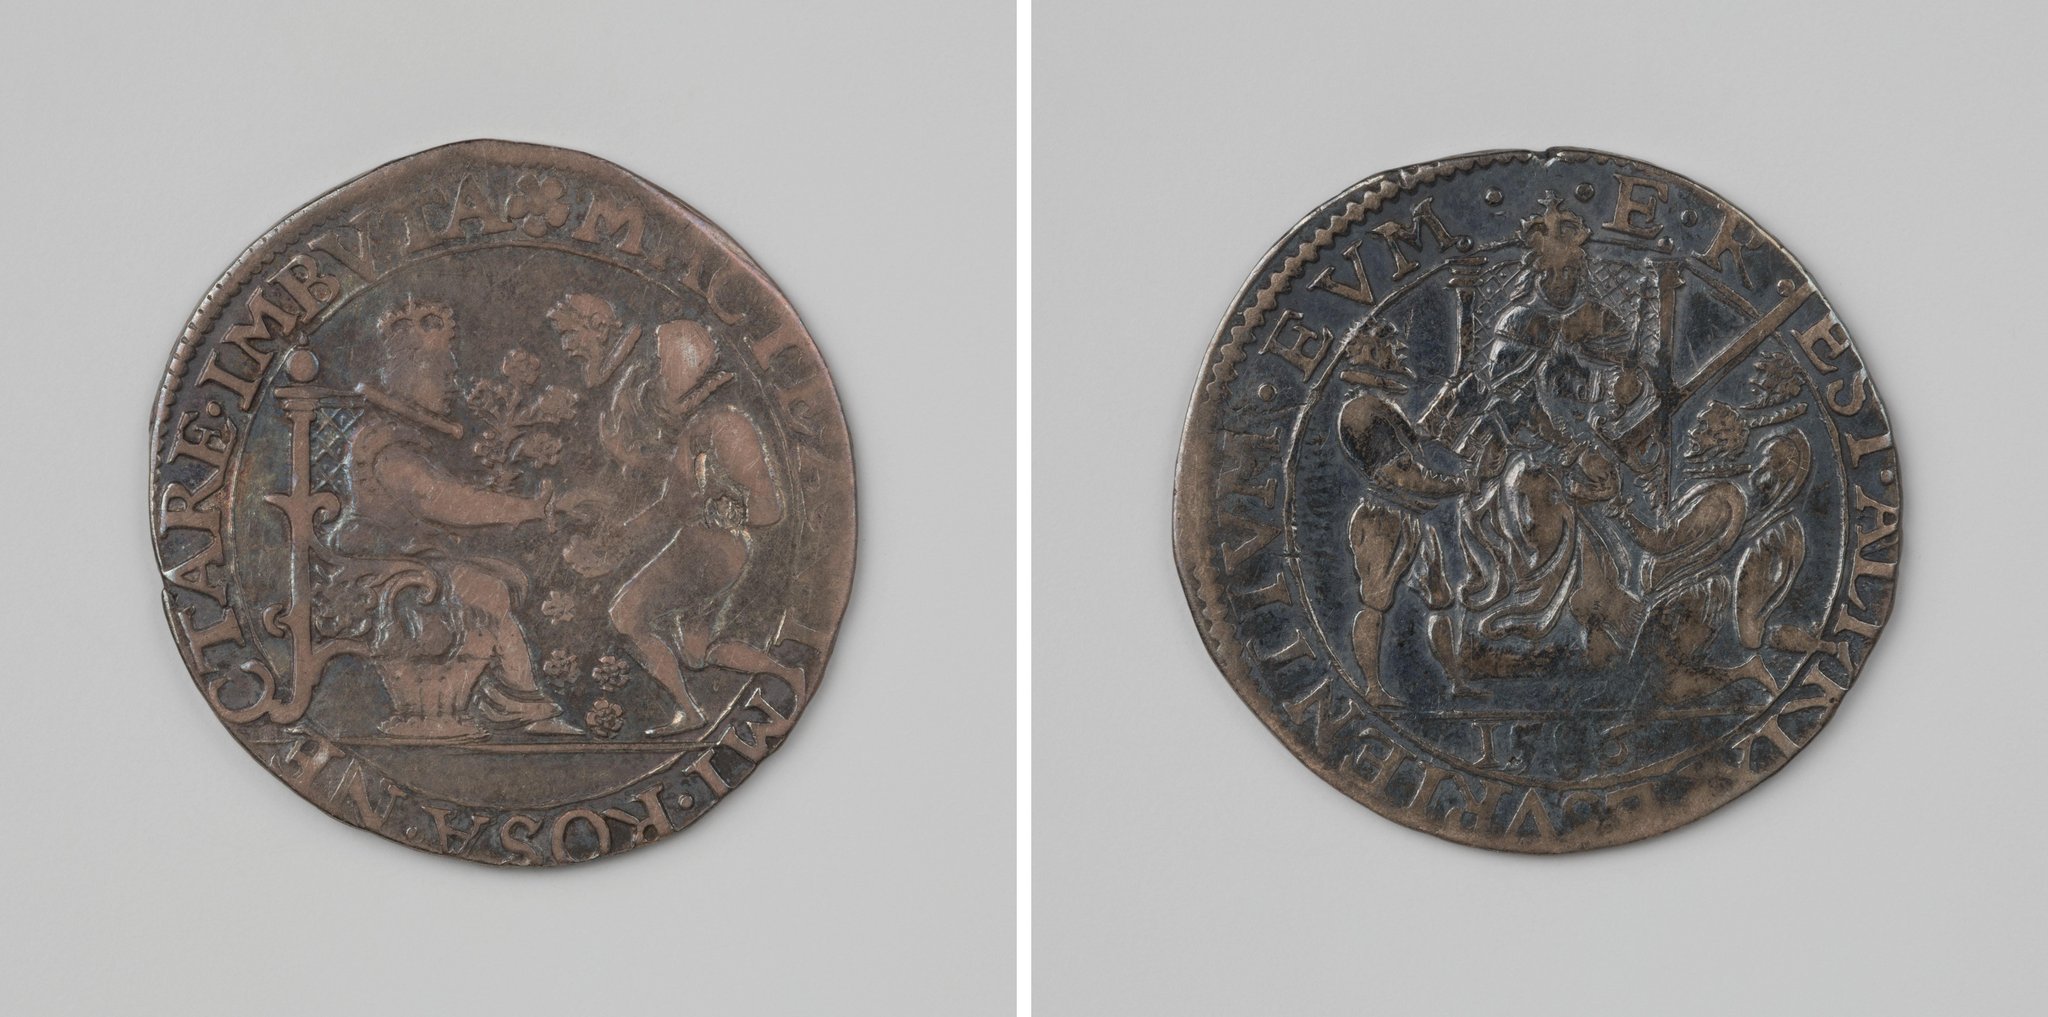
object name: jeton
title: Engelse hulp aan de opstandelingen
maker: Anonymous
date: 1586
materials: silver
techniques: striking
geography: dordrecht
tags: greenwich, koningin, elizabeth i tudor (koningin van engeland), tachtigjarige oorlog